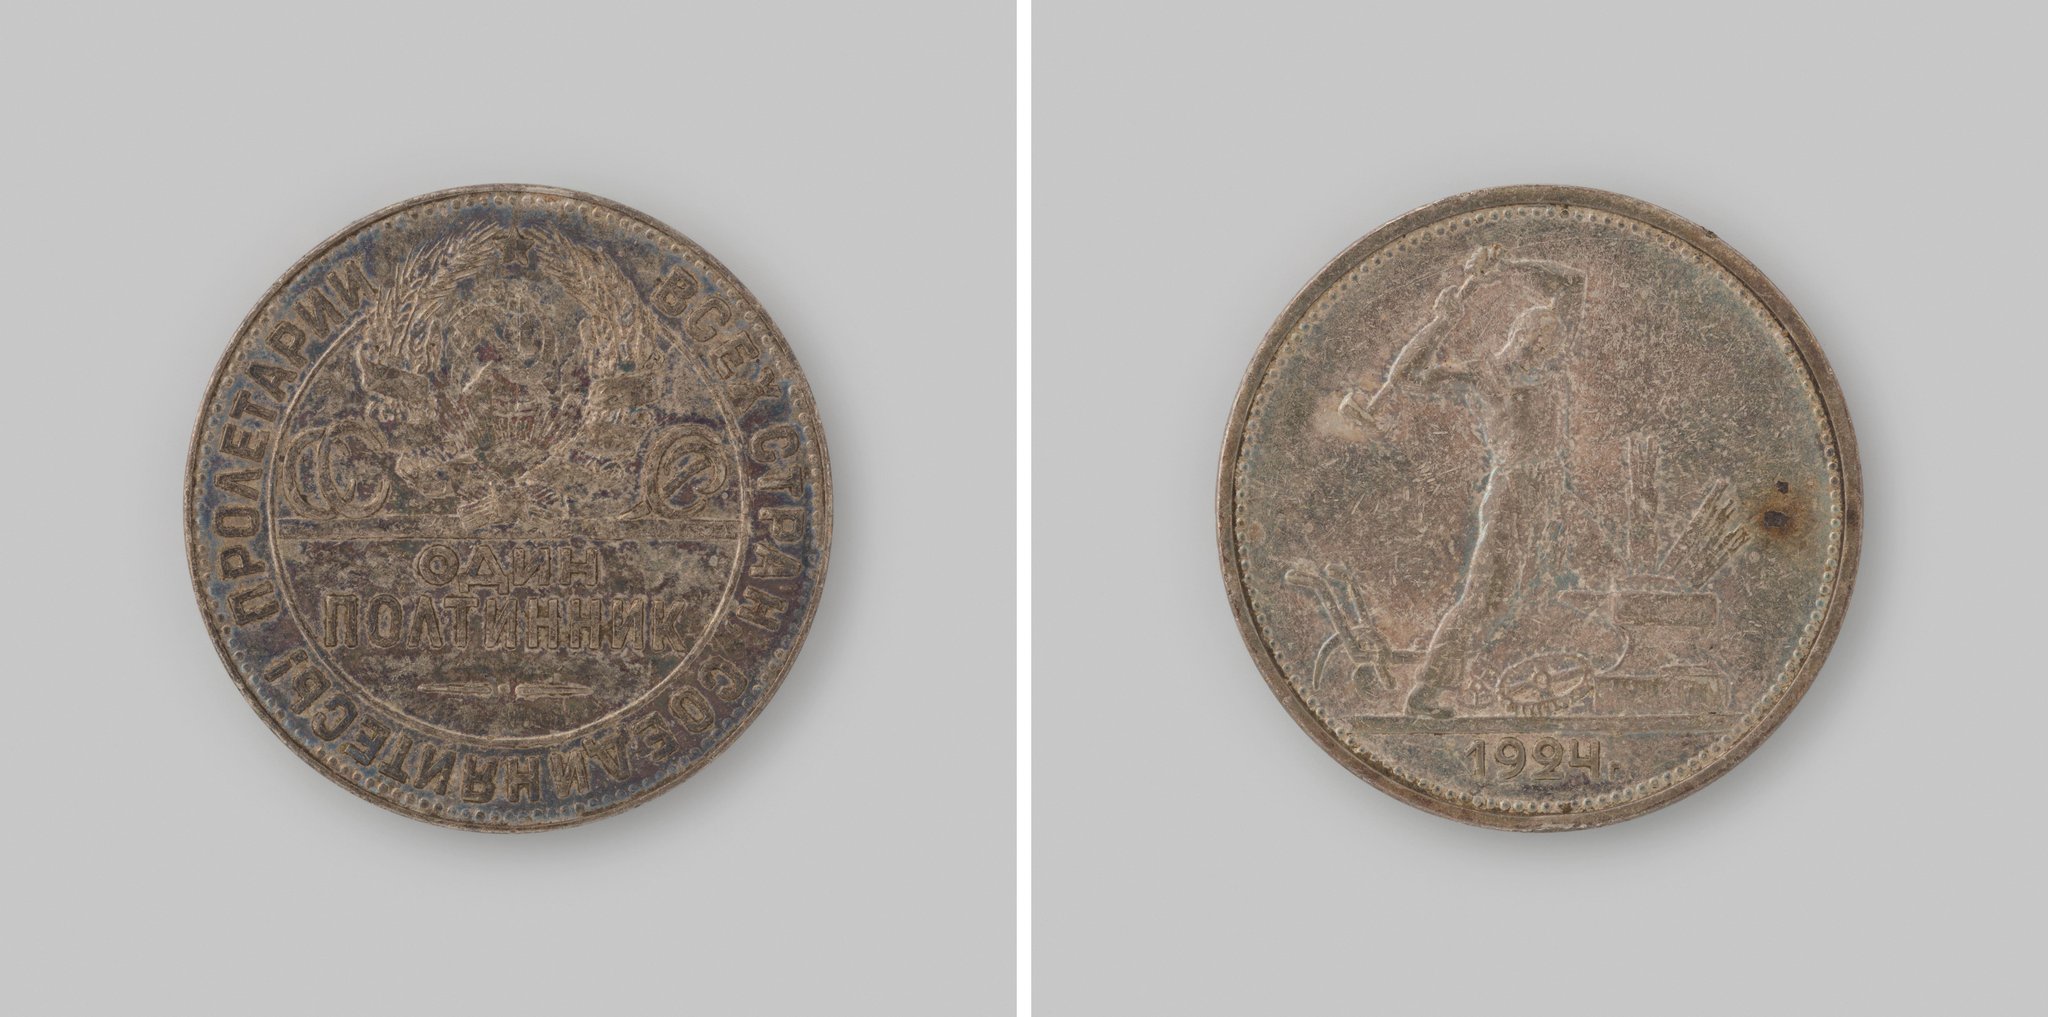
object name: coin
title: Sowjet-Unie, 50 kopeken of poltinnik, 1924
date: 1924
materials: silver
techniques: striking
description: Zilveren munt. Voorzijde: tussen landsaanduiding in Cyrillische letters S,S,S en R wapen van de Sowjet-Unie. in de afsnede waarde-aanduiding: een poltinnik.Keerzijde: door attributern omringde arbeider, slaand op een voorwerp op aambeeld. In de afsnede jaartal. Randschrift.